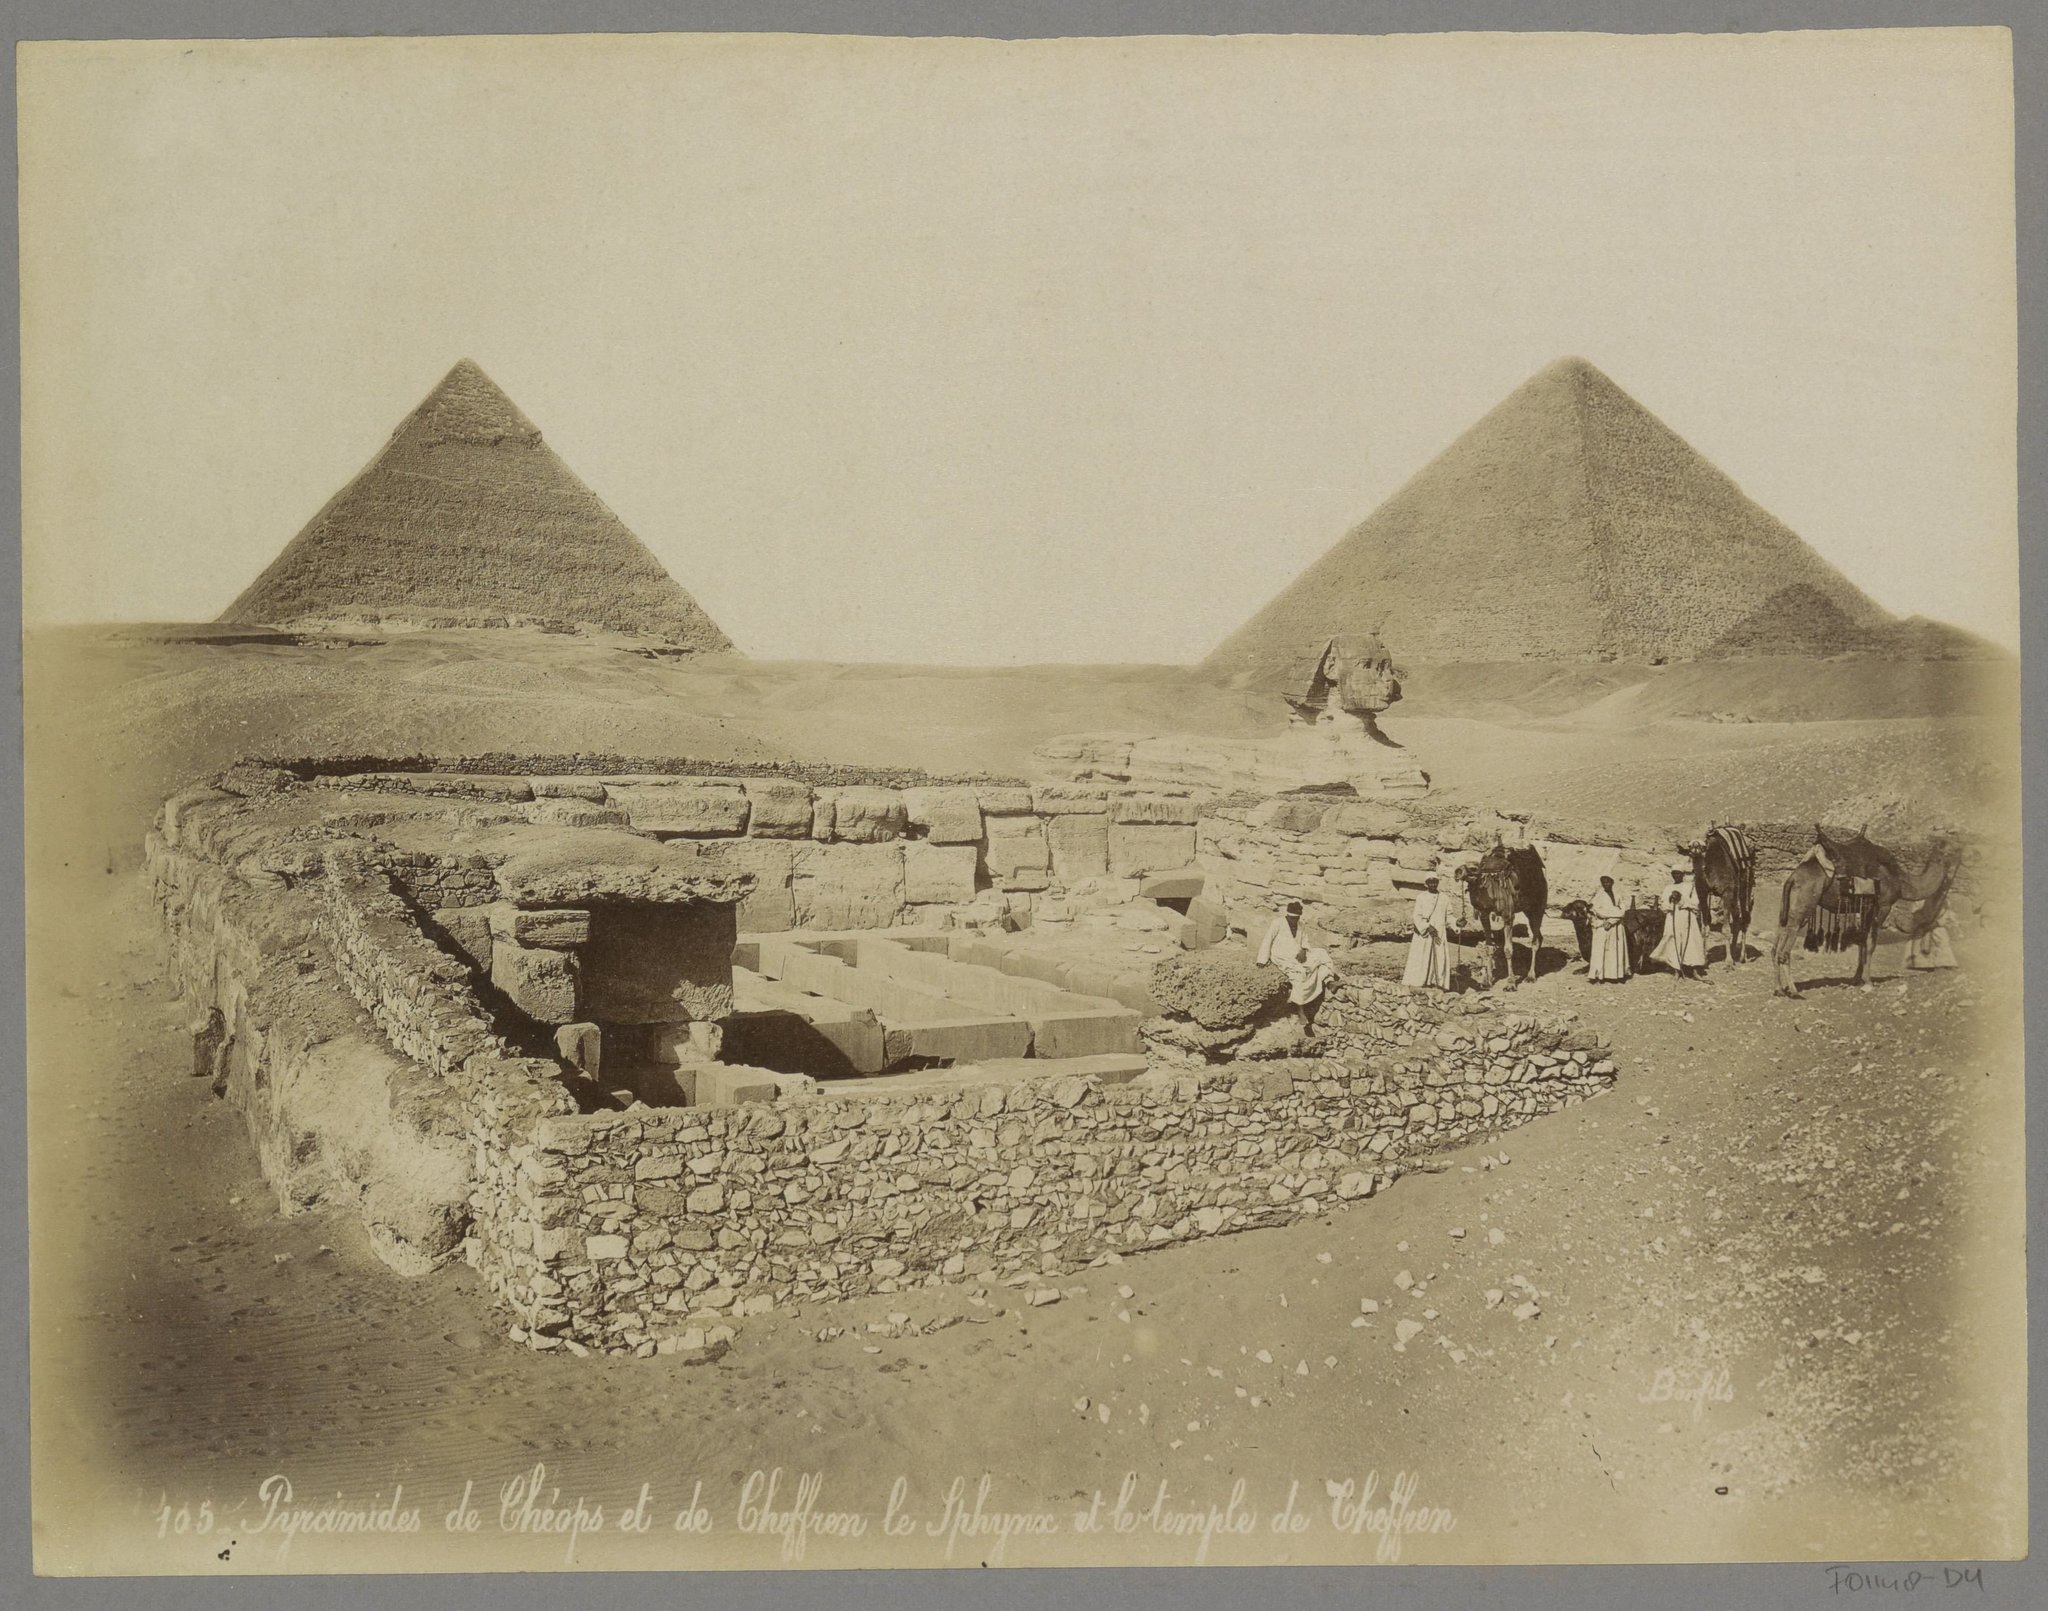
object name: photograph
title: Pyramides de Chéops et de Cheffren le Sphynx et le temple de Cheffren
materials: paper, photographic support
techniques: albumen print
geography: gizeh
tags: sphinx (lion/woman); 'sfinge' (ripa) - aa - female human figure, temple, shrine ~ egyptian religion, pyramid (historical grave form)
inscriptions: negative number: ‘105’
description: Onderdeel van Reisalbum met foto's van bezienswaardigheden in Griekenland en Egypte.